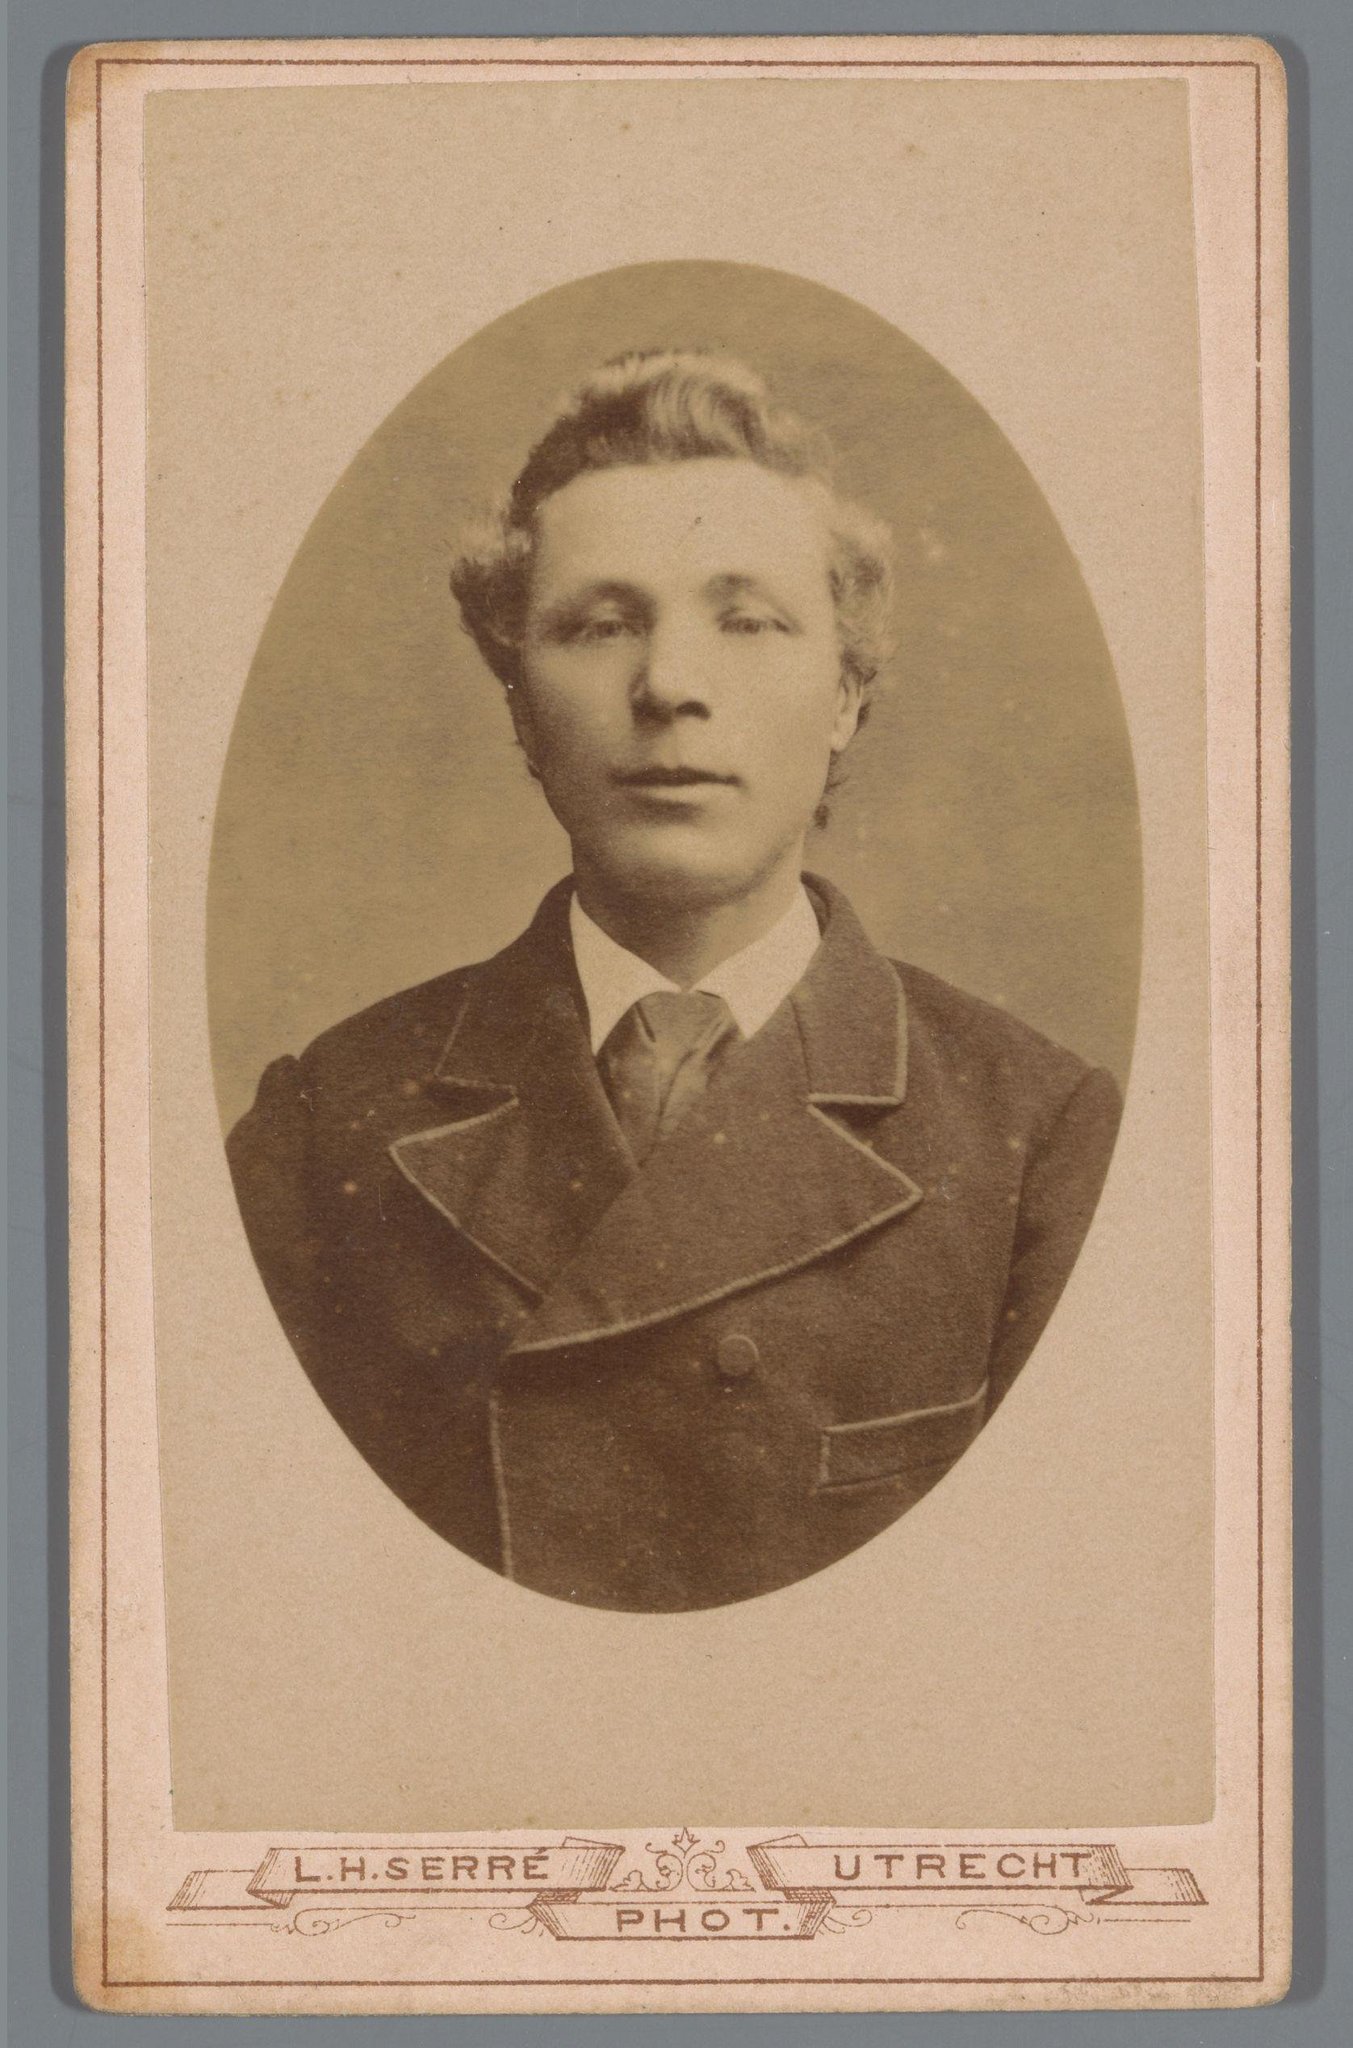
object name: carte de visite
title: Portret van een onbekende man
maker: lodewijk hendrikus serré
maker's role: fotograaf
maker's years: 1847-1897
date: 1877-1897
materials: cardboard, paper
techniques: albumen print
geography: utrecht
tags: youth, adolescent, anonymous historical person portrayed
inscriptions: inscription: ‘Voor nabestelling blyft de plaat bewaard.’, address: ‘NACHTEGAALSTRAAT, over het Park Tivoli/ Utrecht/ 's Hage, Tiel en Arnhem.’